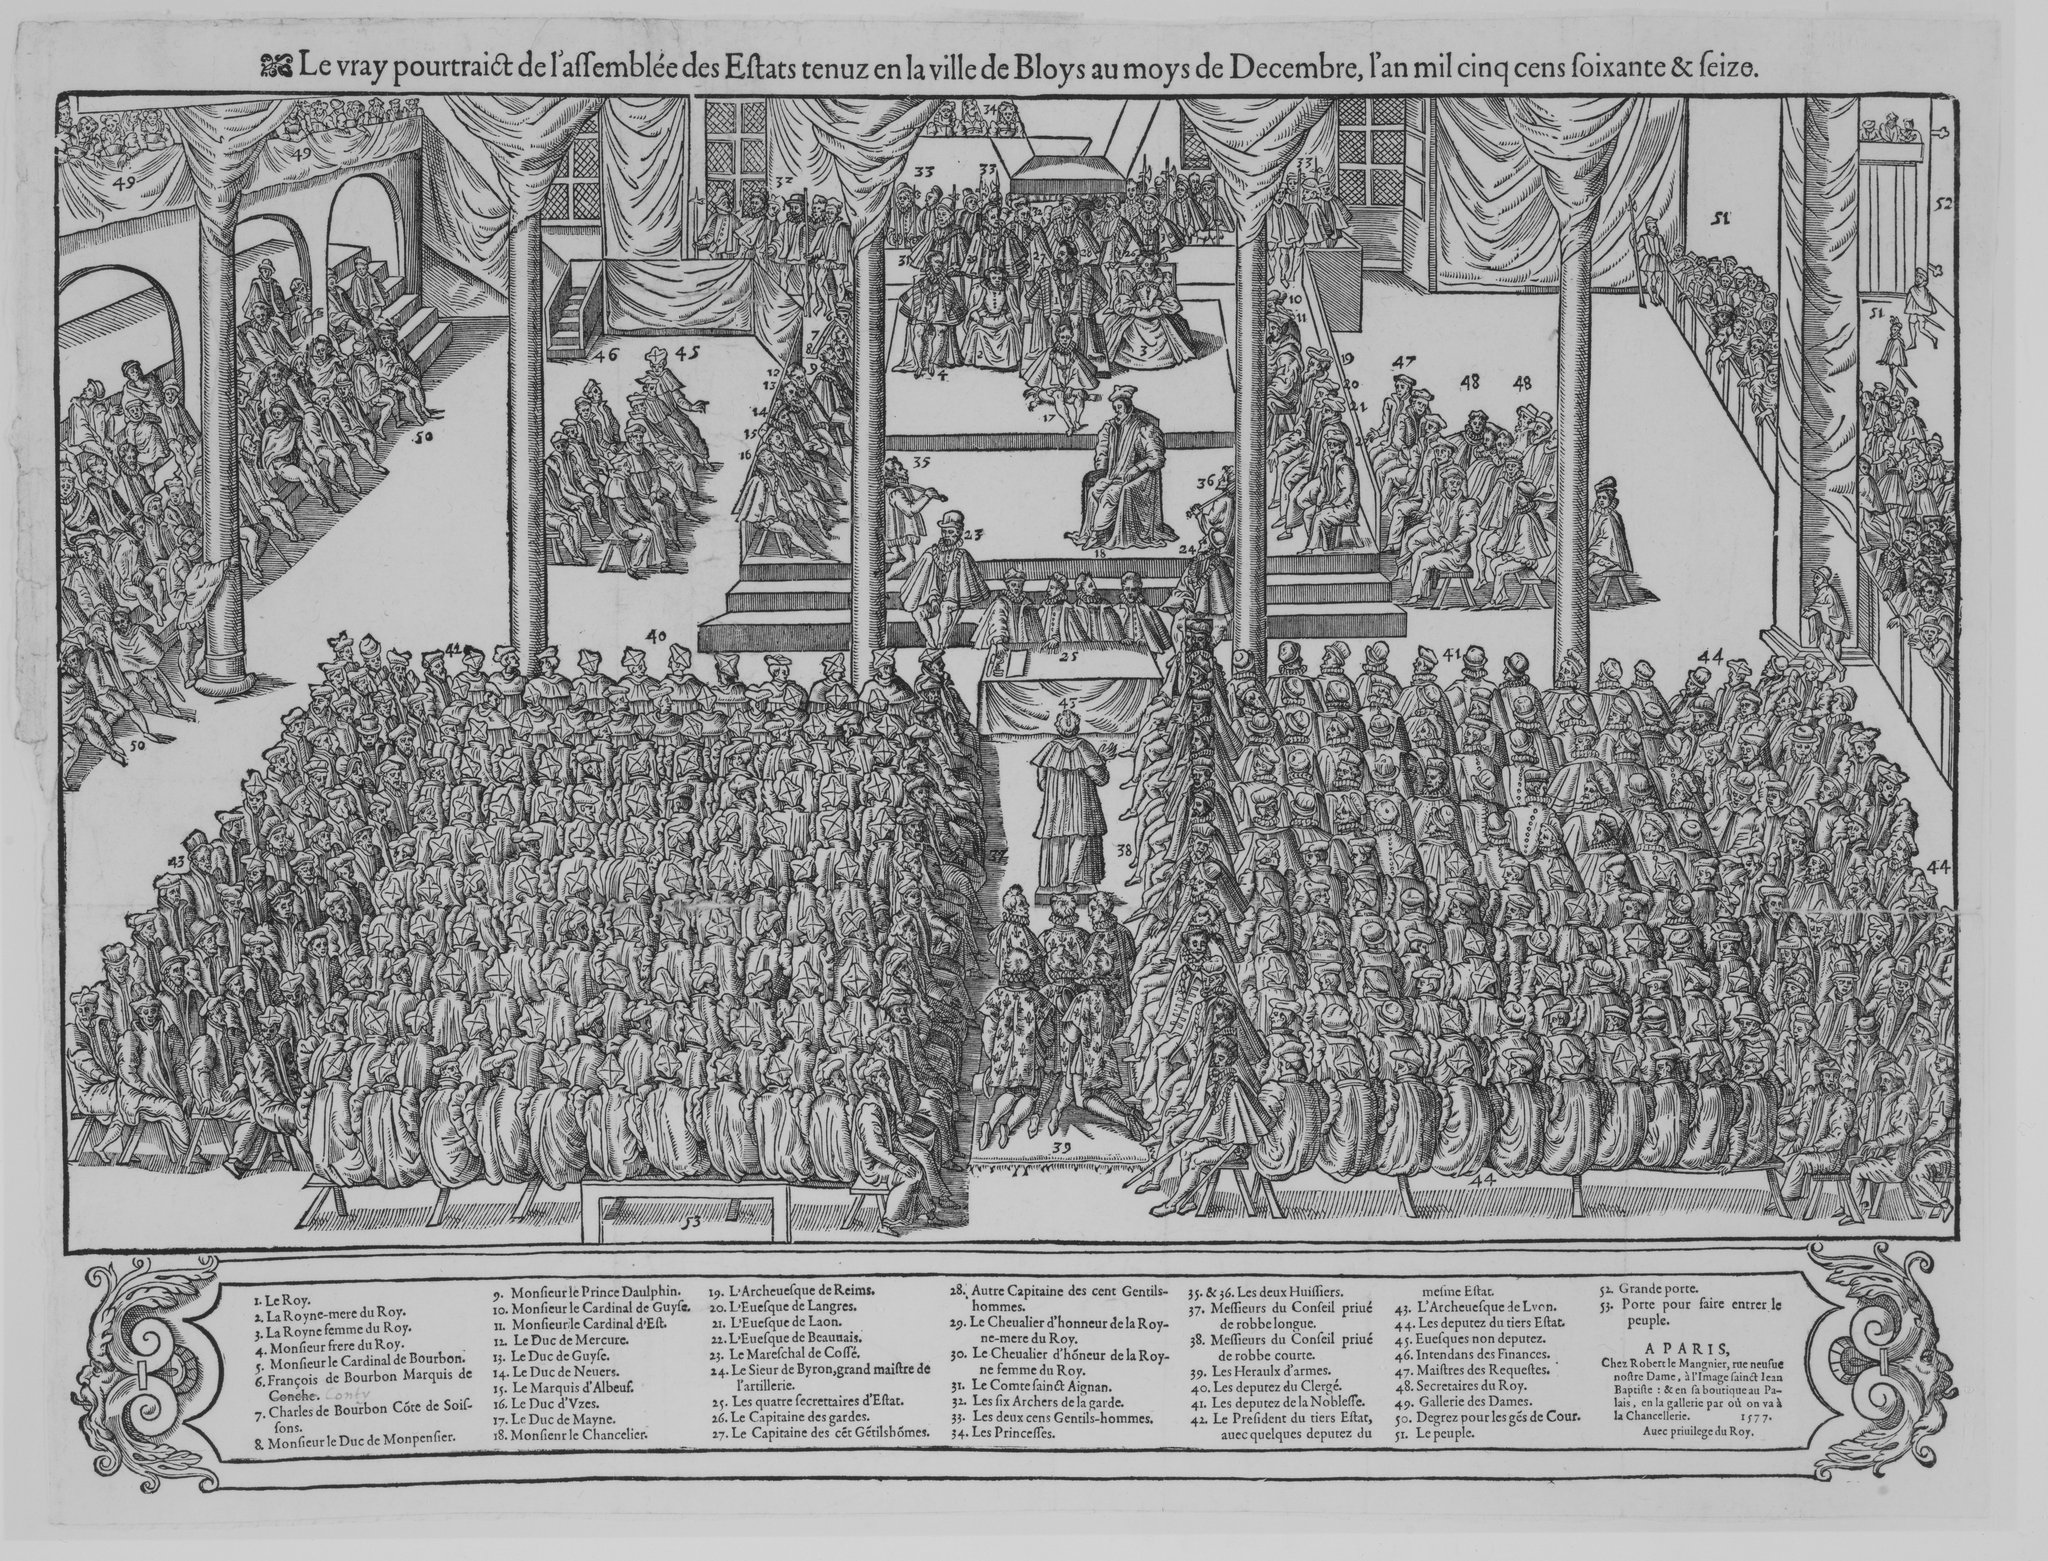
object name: print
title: Le vray pourtraict de l'assemblee des Estats tenuz en la ville de Bloys au moys de Decembre, l'an mil cinq cens soixante & seize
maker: anonymous, french, 16th century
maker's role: artist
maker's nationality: french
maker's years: 1500-1600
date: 1577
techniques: woodcut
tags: men